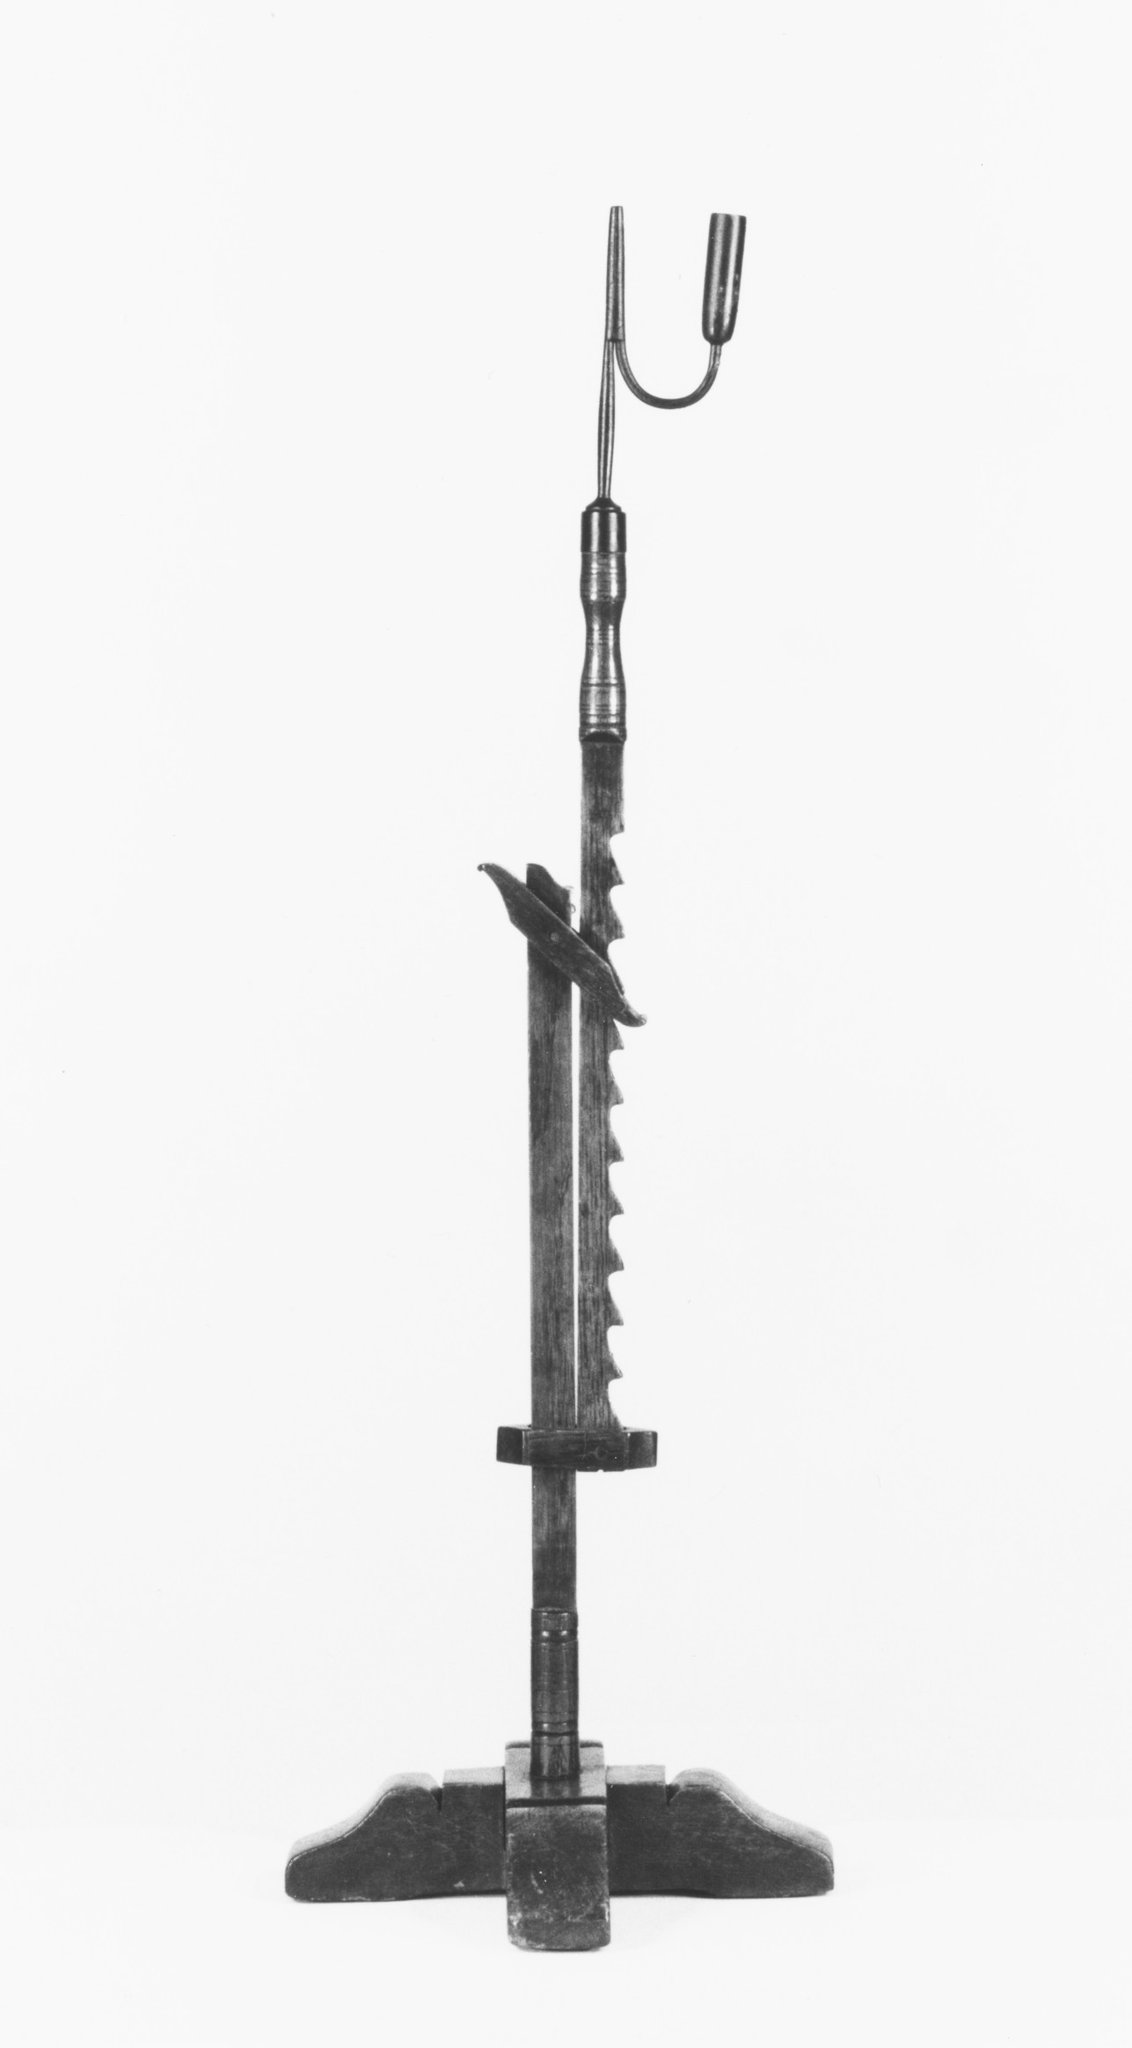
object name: candle stand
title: Candlestand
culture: american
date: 1750-1800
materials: wood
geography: united states